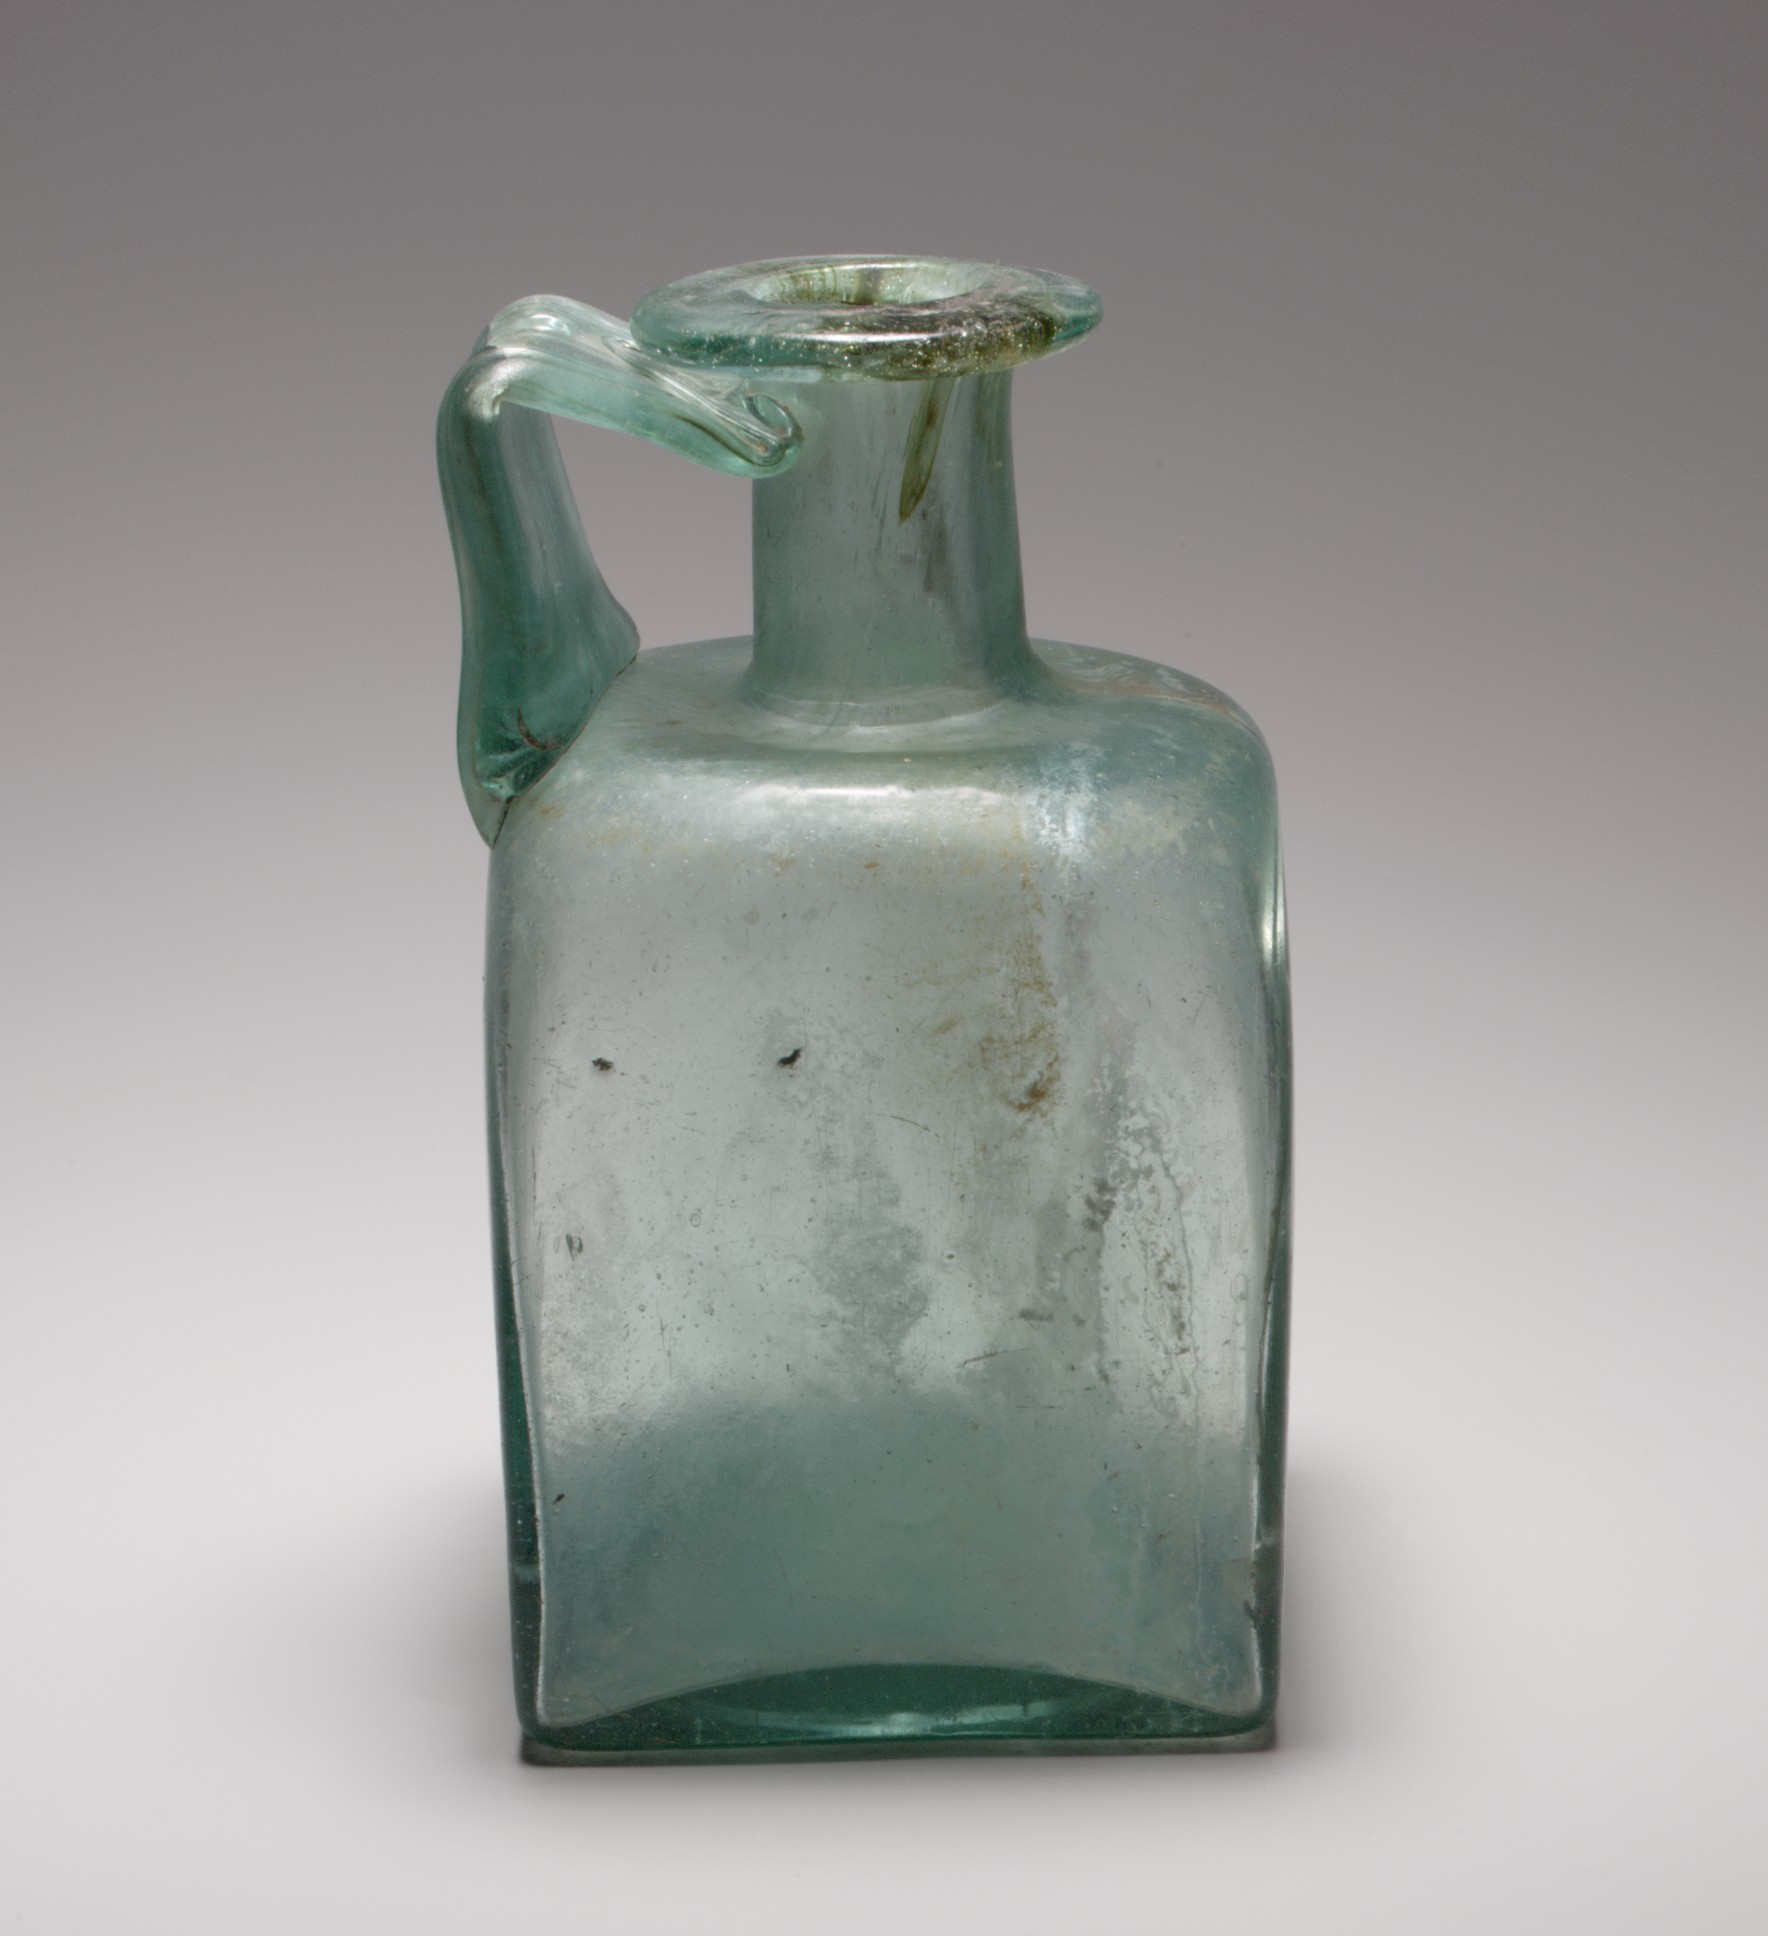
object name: bottle, square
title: Glass square bottle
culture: roman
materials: glass